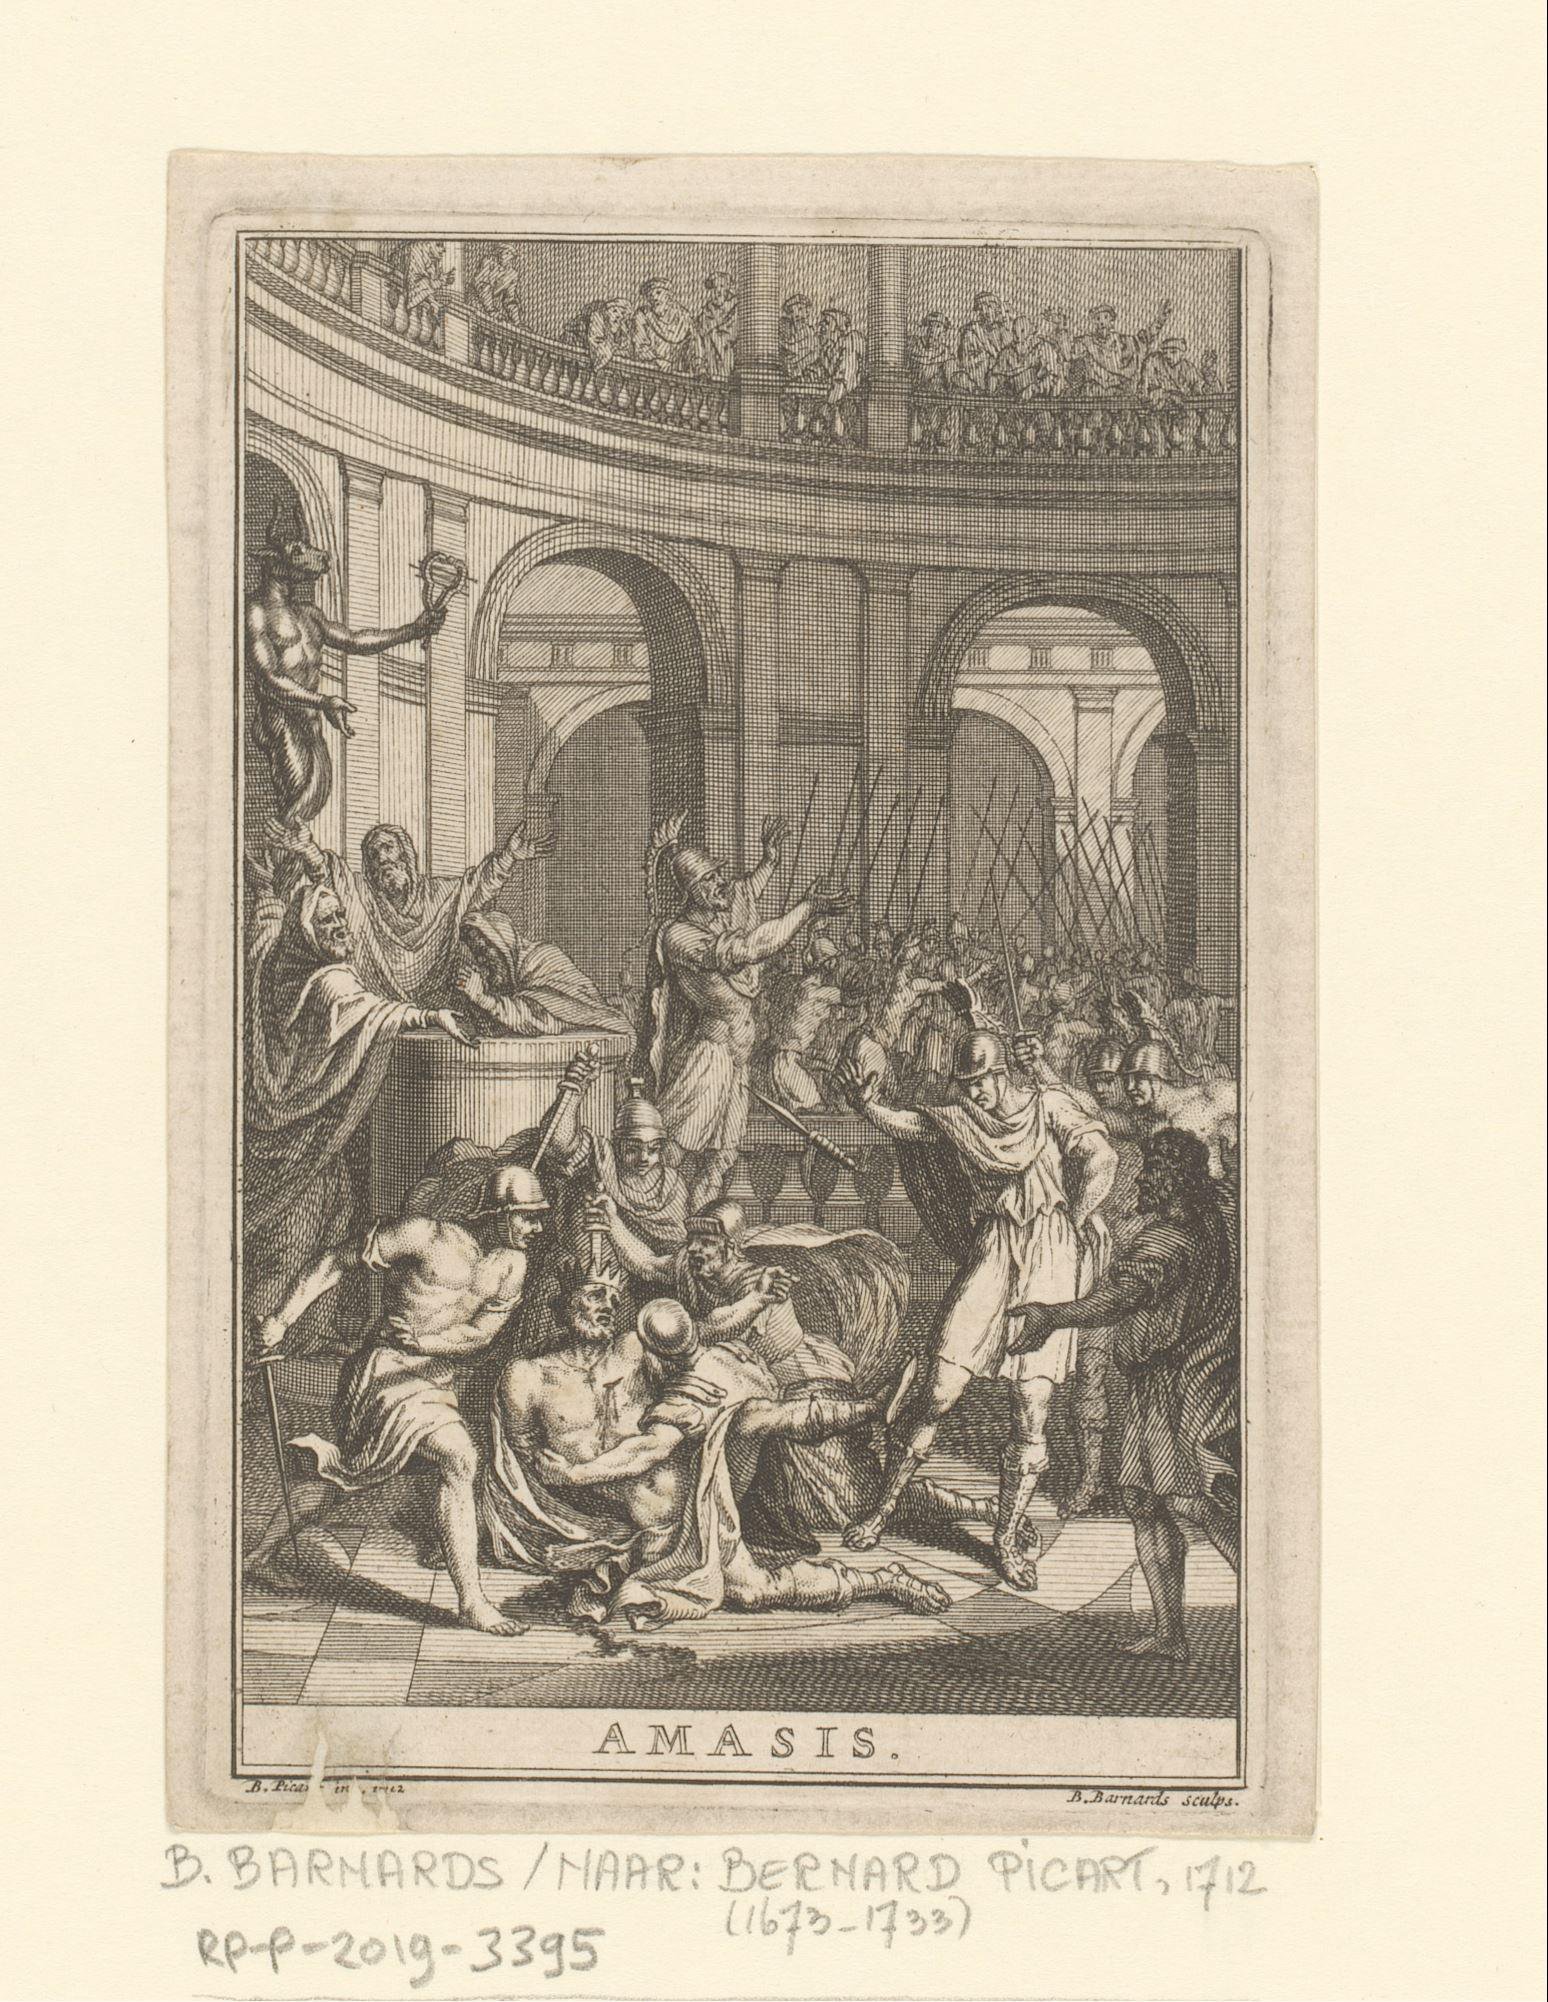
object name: print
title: Amasis wordt in zijn paleis neergestoken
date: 1712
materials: paper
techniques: engraving, etching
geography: amsterdam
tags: regicide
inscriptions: collector's mark: Lugt 2228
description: Prent komt uit een vermoedelijk Franse editie van 'Amasis: tragedie', door François Joseph de Lagrange Chancel. Het stuk werd in 1712 in bewerkte versie uitgegeven in het Nederlands, onder de titel 'Sesostris, koning van Egipte: treurspel'.